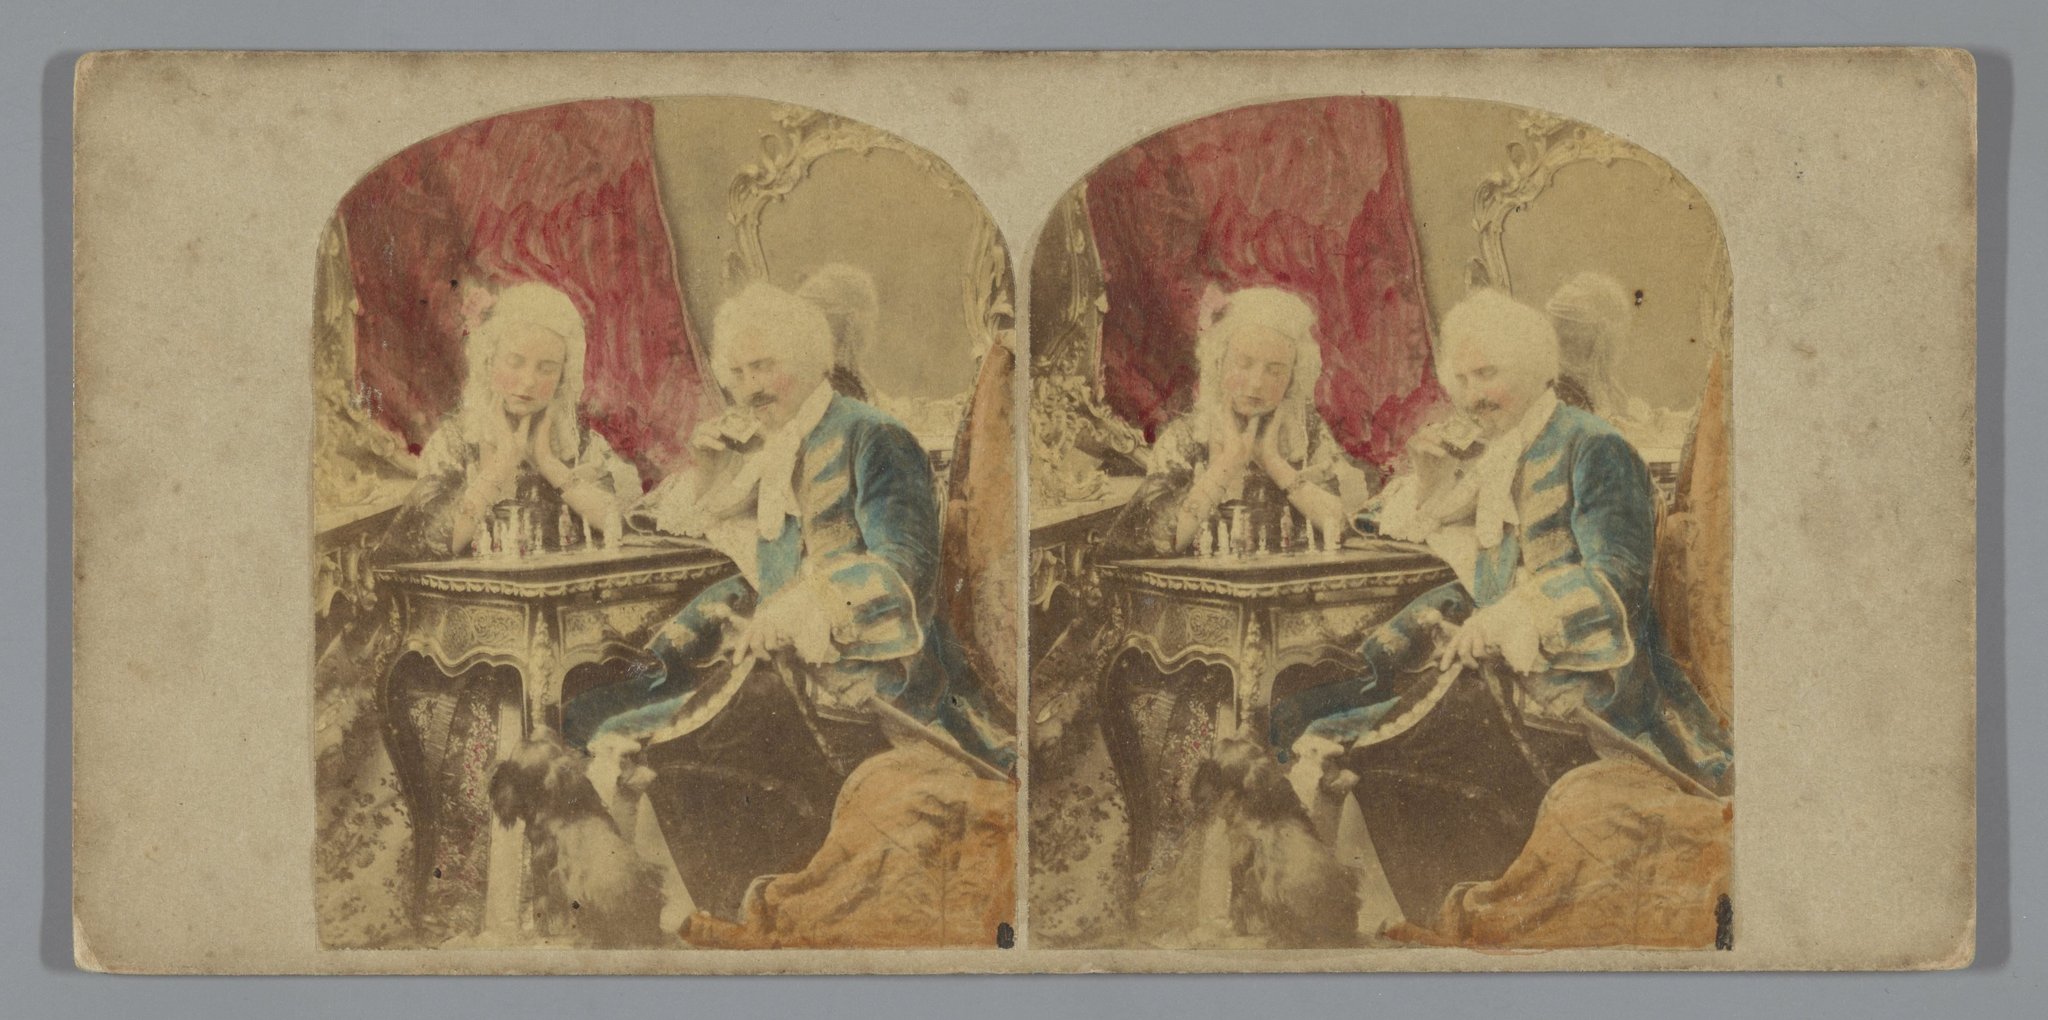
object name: stereograph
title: Man en een vrouw spelen een schaakspel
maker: Anonymous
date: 1852-1863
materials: cardboard, paper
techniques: albumen print, hand coloring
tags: adult woman, chess, adult man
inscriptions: inscription: ‘Simons’